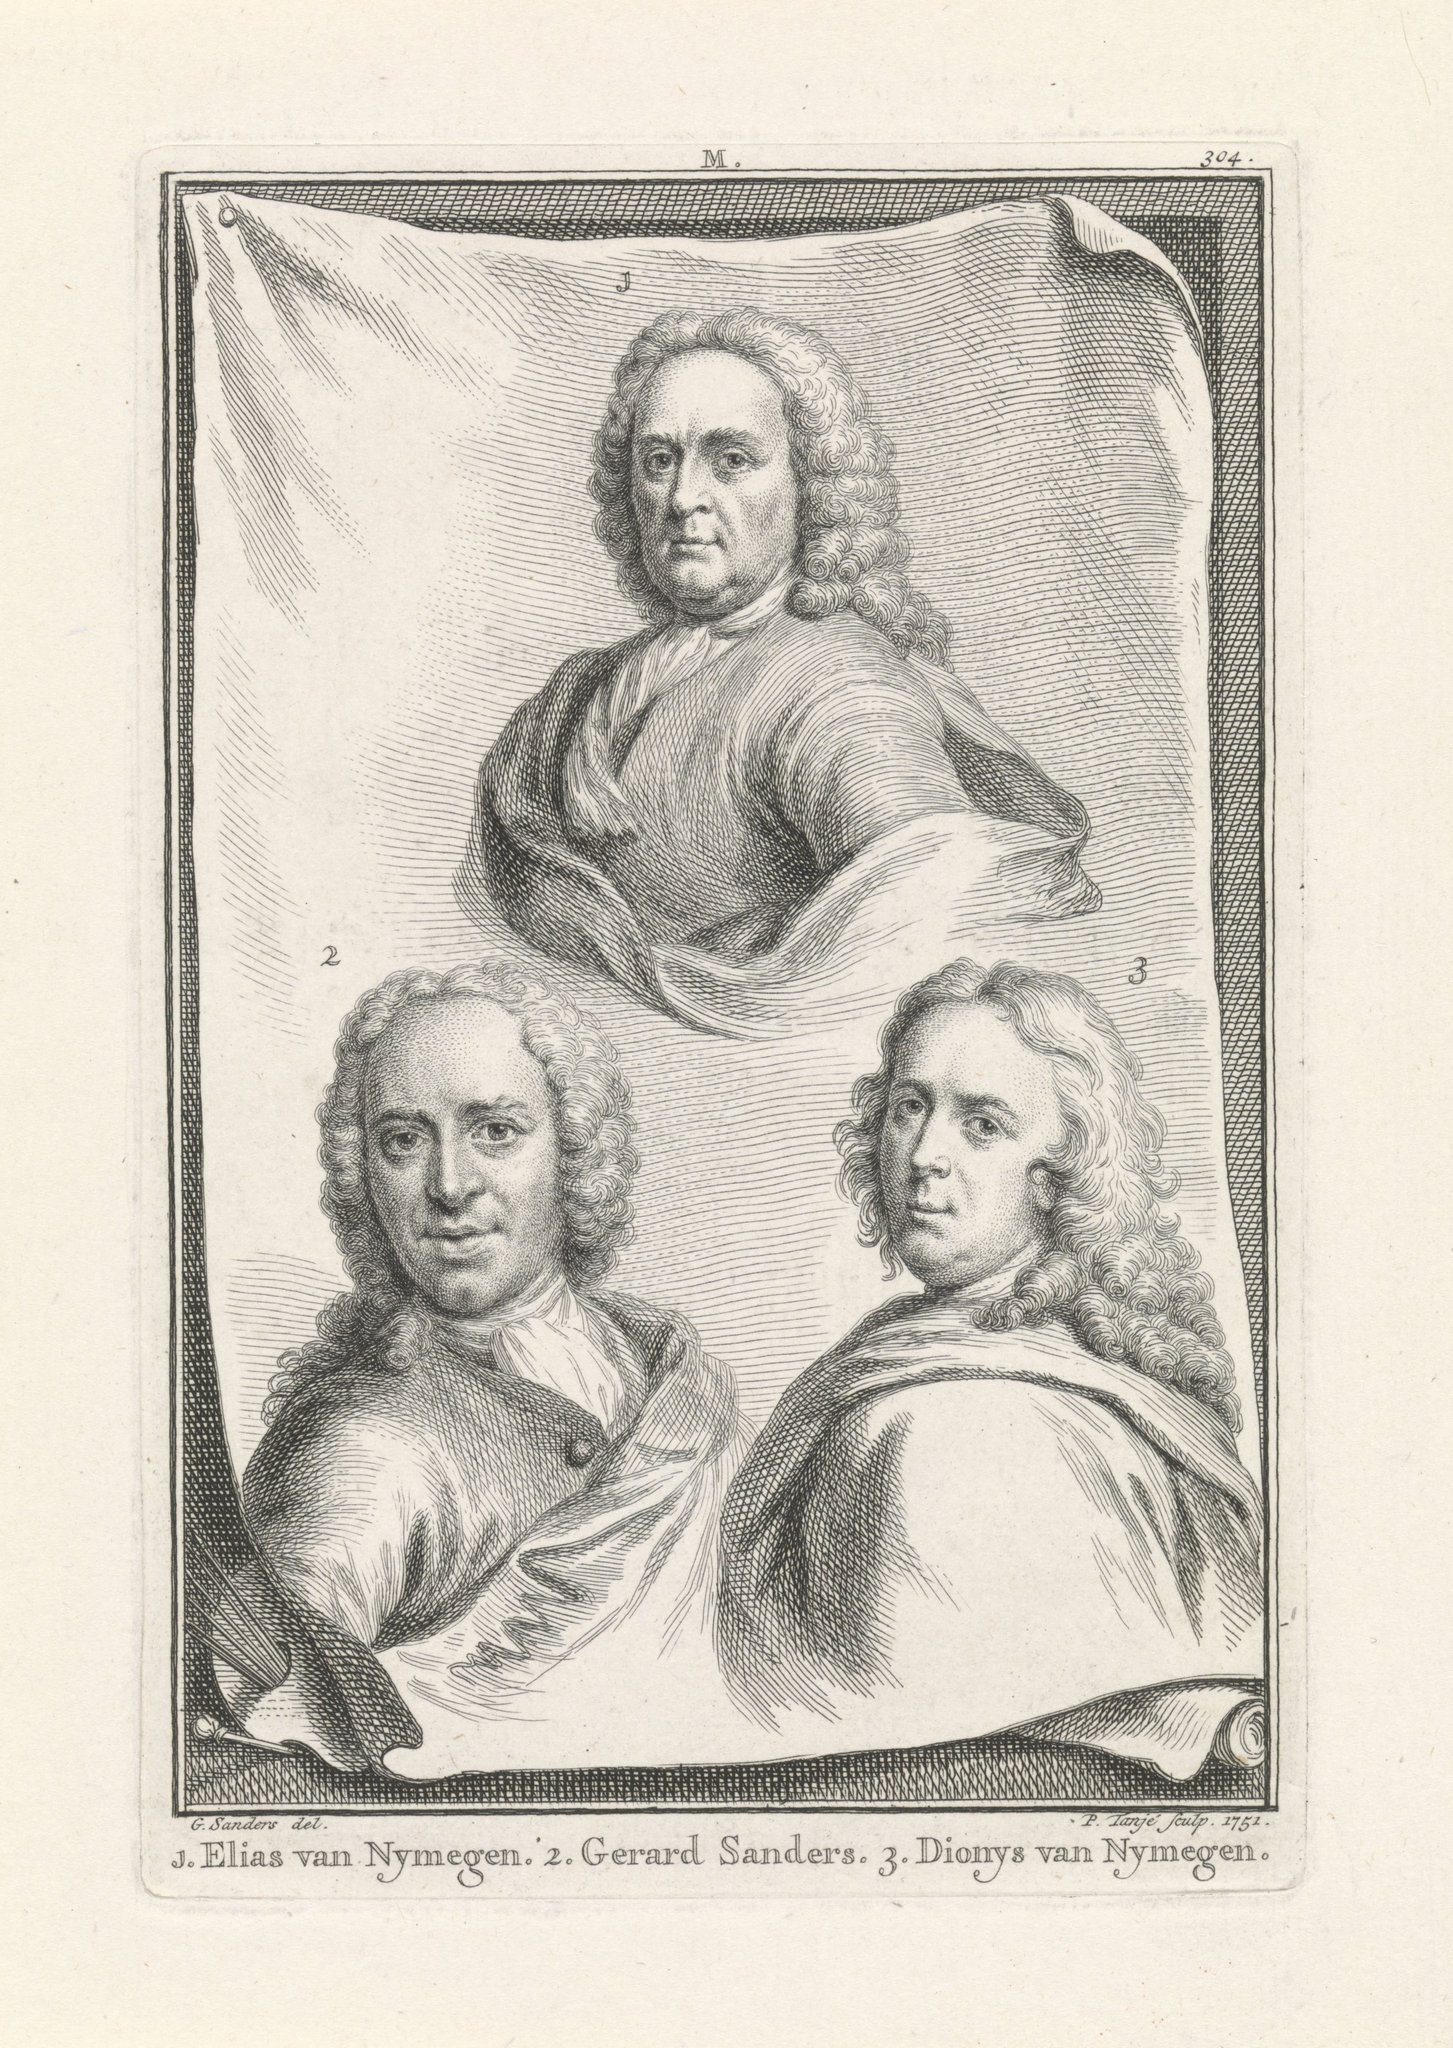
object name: book illustration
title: Portretten van Elias van Nijmegen, Gerard Sanders en Dionys van Nijmegen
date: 1751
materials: paper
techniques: engraving, etching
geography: amsterdam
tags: rotterdam, painter, dionys van nijmegen, gerard sanders, elias van nijmegen, portrait, self-portrait of artist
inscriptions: collector's mark: Lugt 240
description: Drie genummerde portretten van de schilders Elias van Nijmegen, Gerard Sanders en Dionys van Nijmegen. Linksonder een palet en penselen. Midden boven: M.